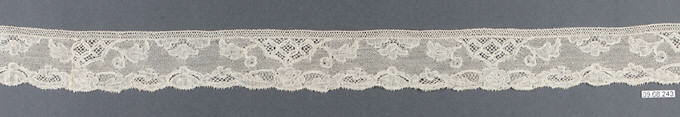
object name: strip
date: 1701-1733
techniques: lace